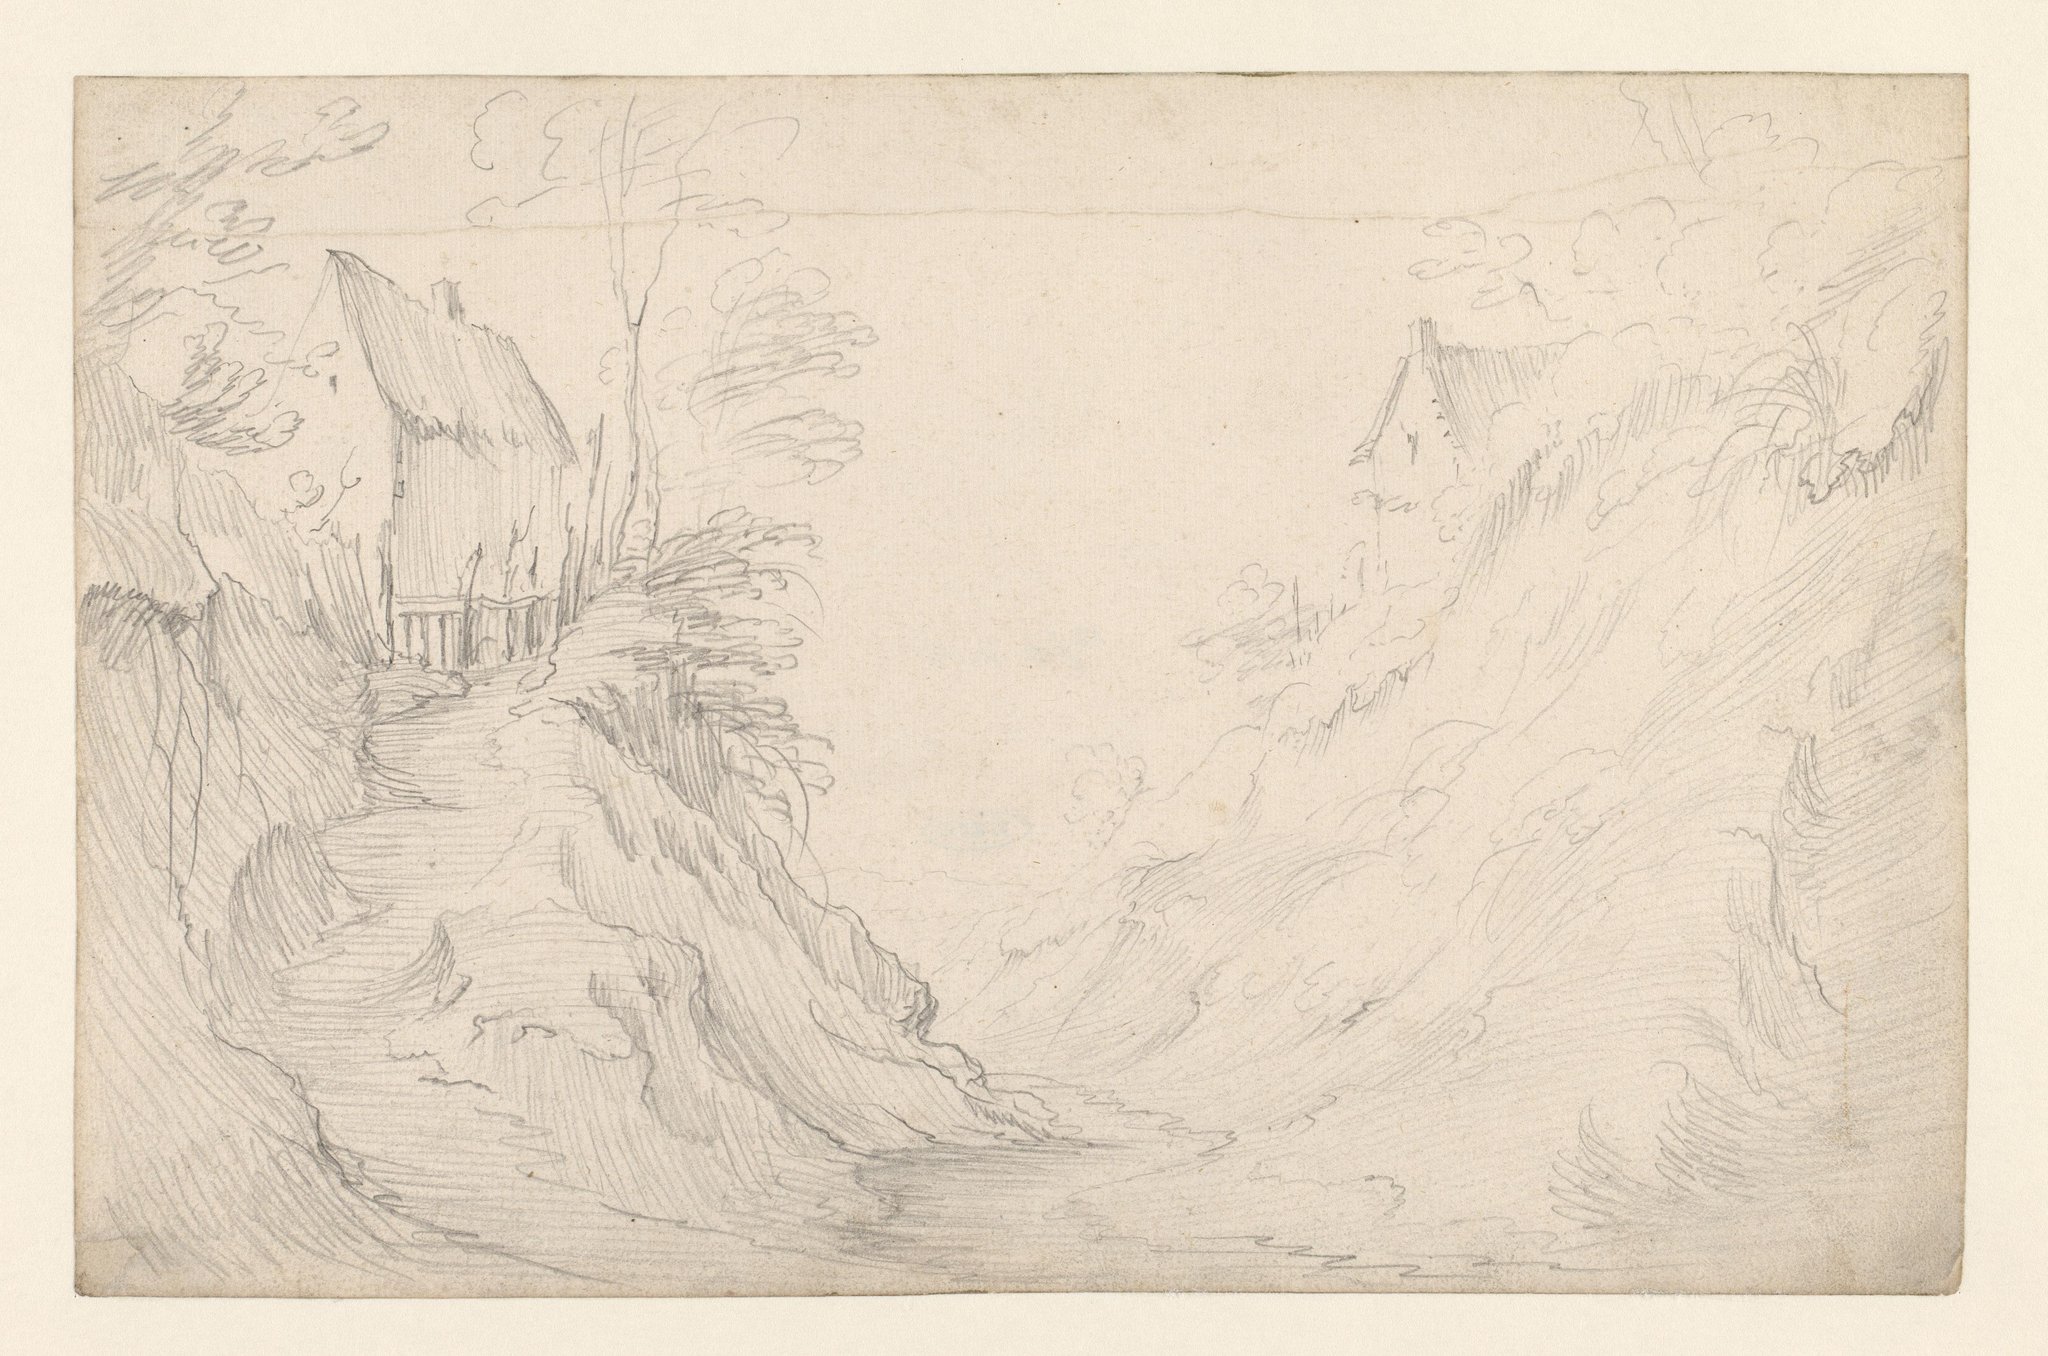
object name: drawing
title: Landschap met beekje tussen twee heuveltjes waarop huizen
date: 1620-1690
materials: paper, pencil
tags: low hill country